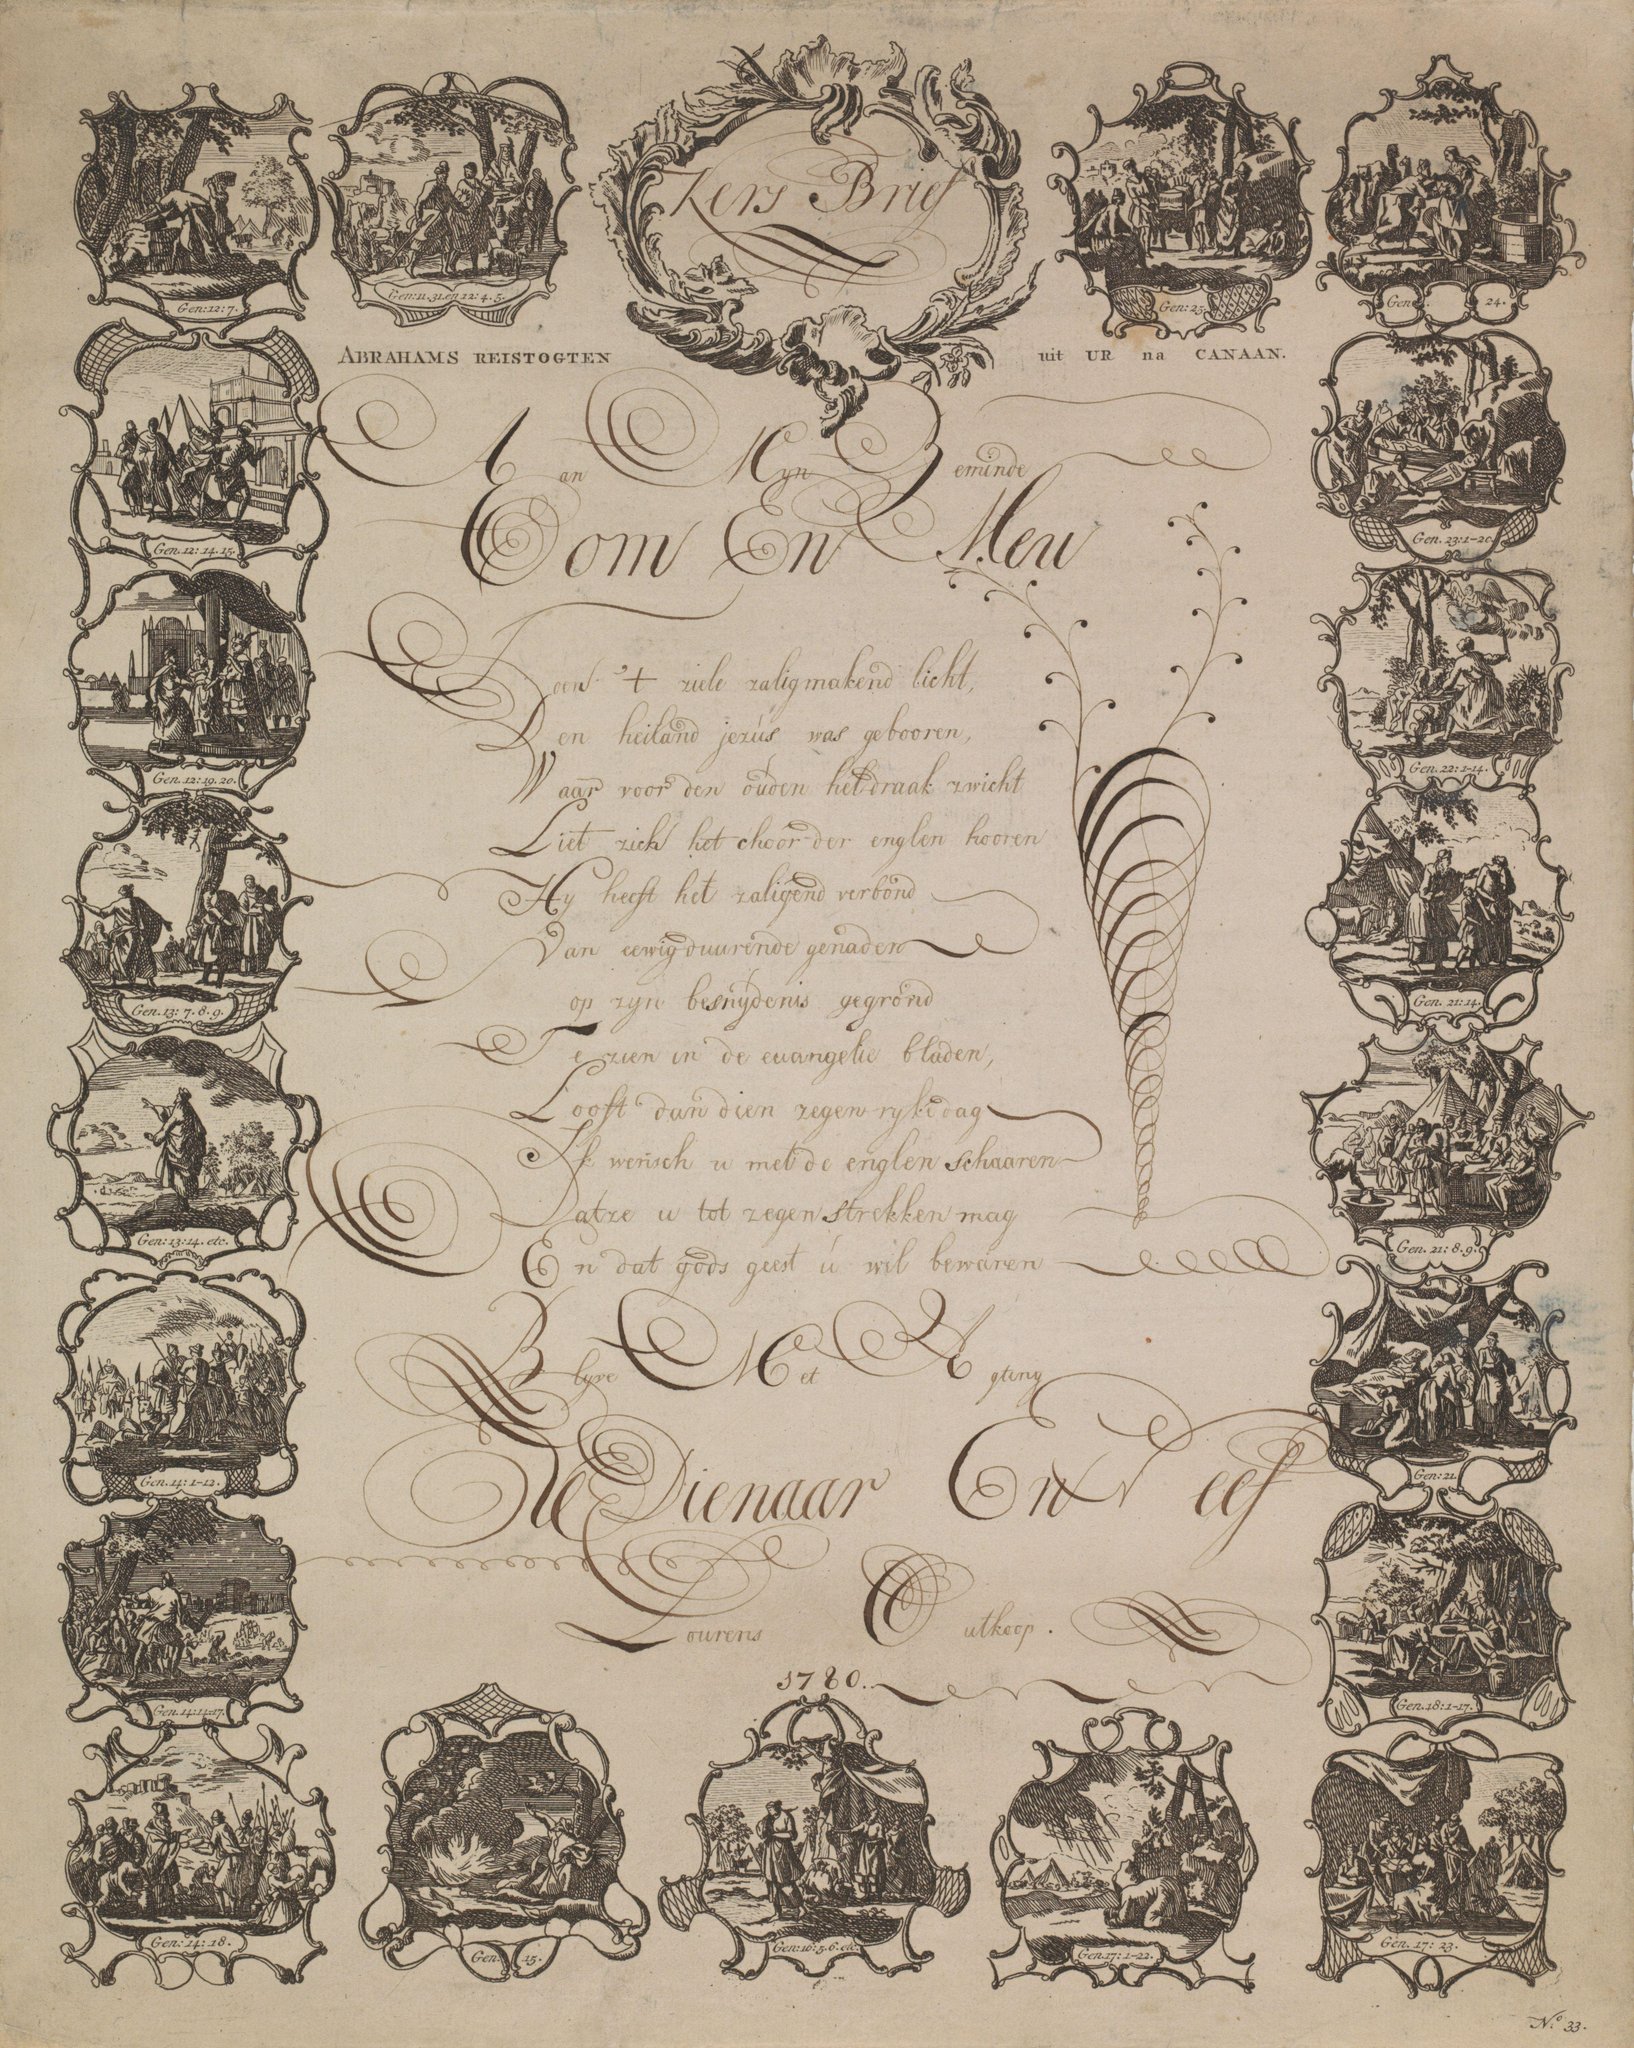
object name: wensbrief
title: Abrahams reistogten uit Ur na Canaan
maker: Anonymous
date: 1780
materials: ink, paper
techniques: calligraphy, etching, pen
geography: netherlands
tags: story of abraham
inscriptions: collector's mark: Lugt 2760, inscription: ‘Kers brief / Aan myn beminde / oom en meu / Toe 't ziele zaligmakend licht ...’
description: Wensbrief met beschreven cartouche binnen een decoratief kader met voorstellingen van de reizen van Abraham. Handgeschreven bericht in kalligrafie (Kerstbrief) door Lourens Outkoop aan zijn oom en meu. Genummerd rechtsonder: No. 33.